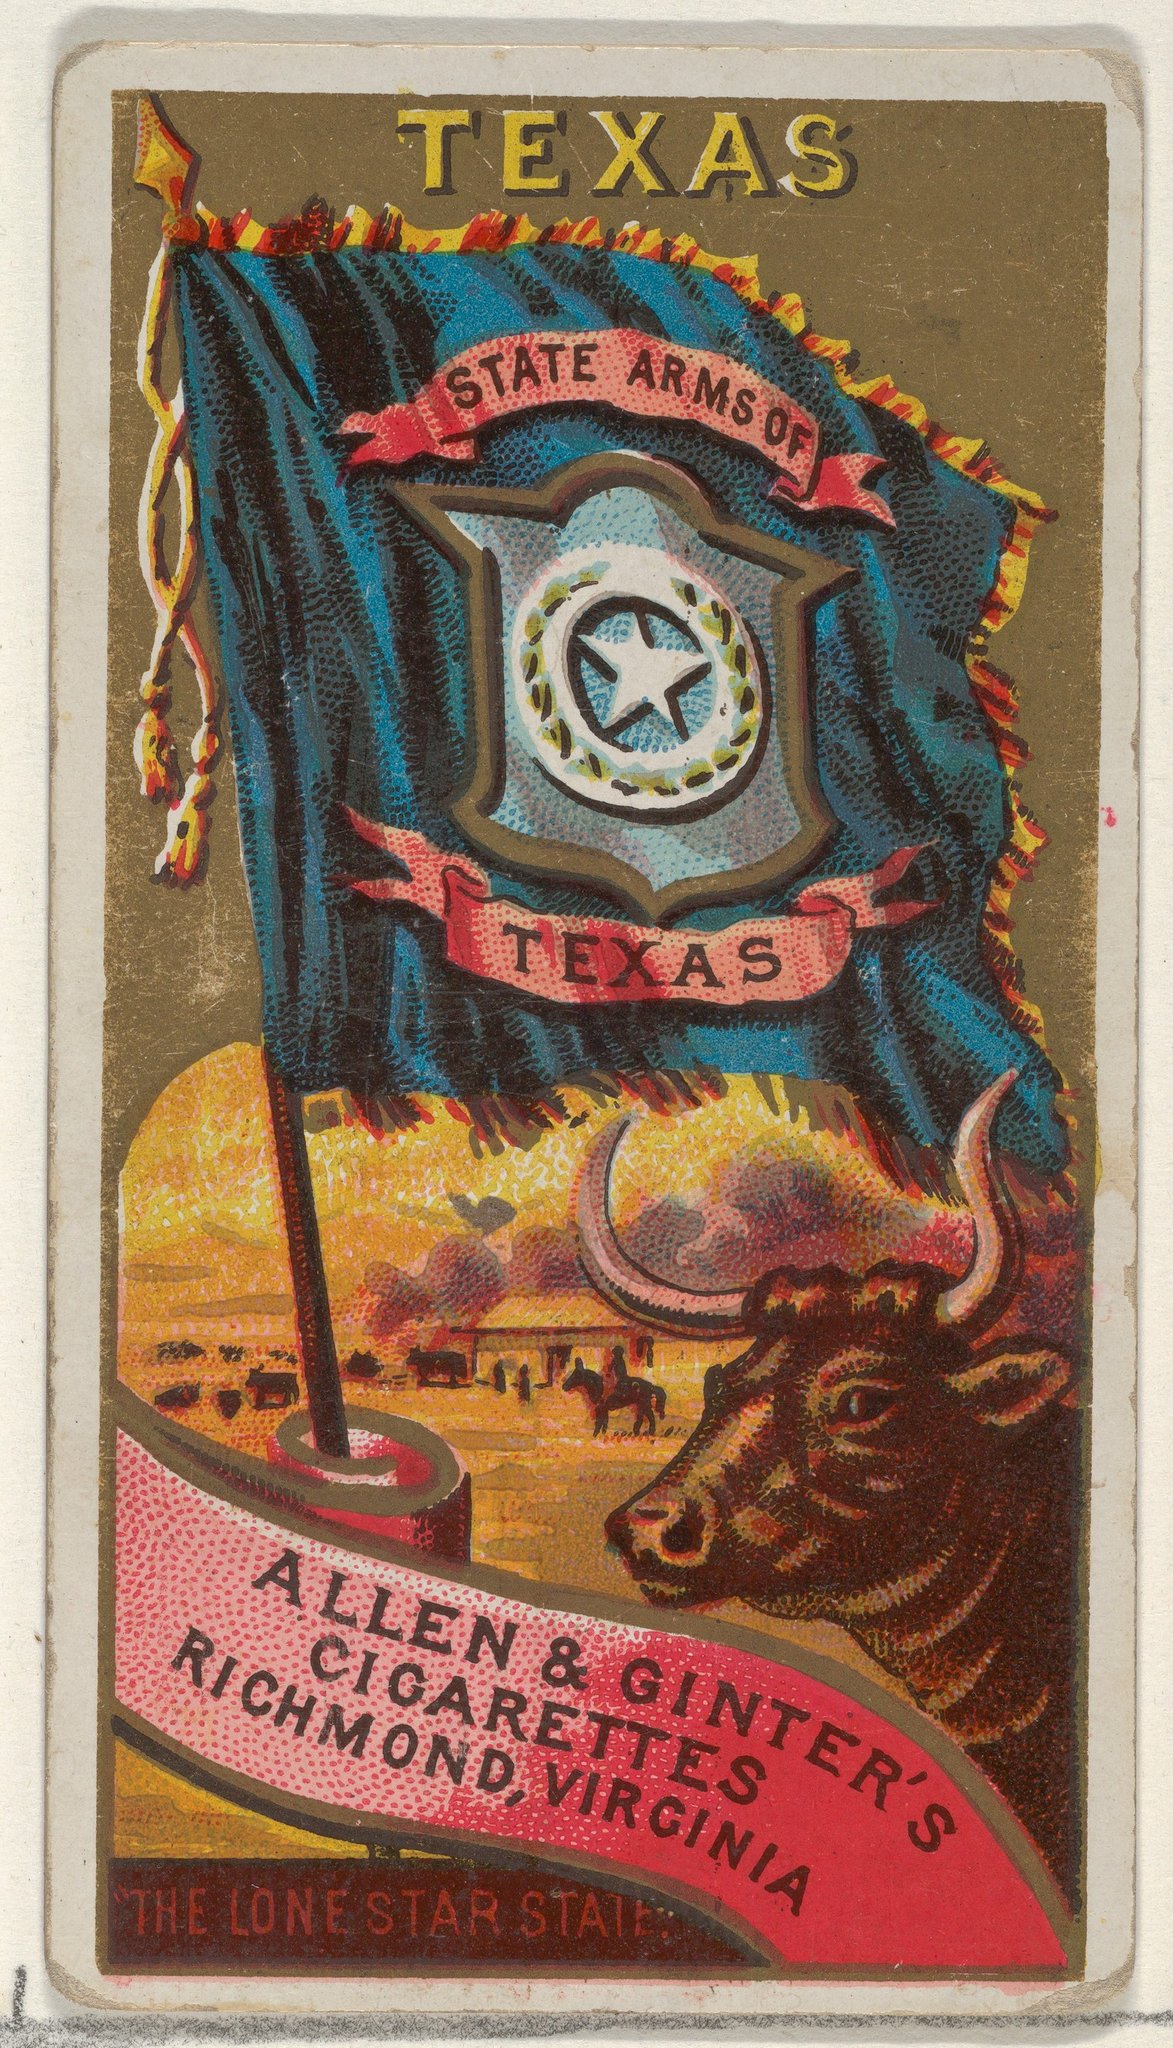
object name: print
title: Texas, from Flags of the States and Territories (N11) for Allen & Ginter Cigarettes Brands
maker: allen & ginter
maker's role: publisher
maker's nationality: american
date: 1888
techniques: color lithograph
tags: flags